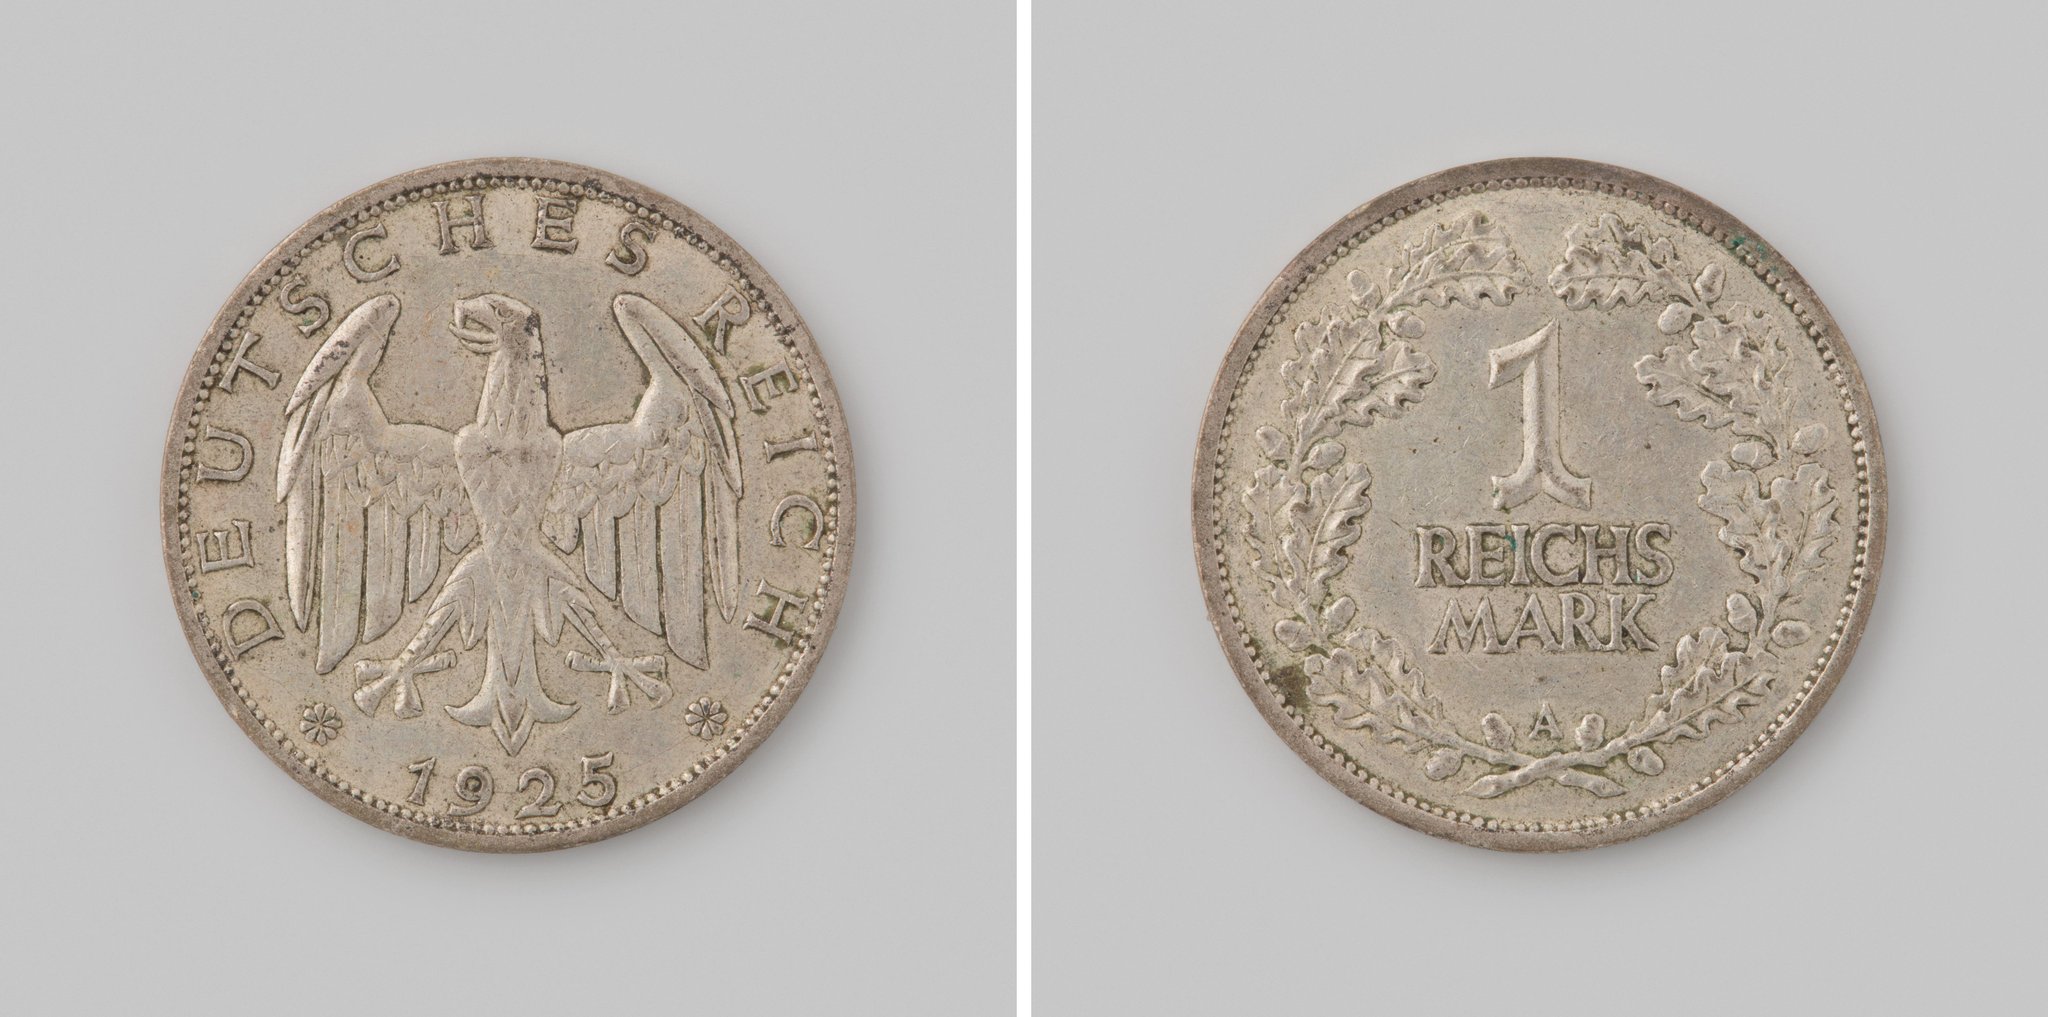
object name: reichsmark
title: Duitsland, Reichsmark, 1925 A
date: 1925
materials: silver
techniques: striking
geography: berlin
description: Zilveren munt. Voorzijde: enkelkoppige adelaar naar links. Jaartal onderaan. Keerzijde: binnen twee samengebonden eiketakken waarde-aanduiding in twee regels, waaronder letter A. Randversiering.